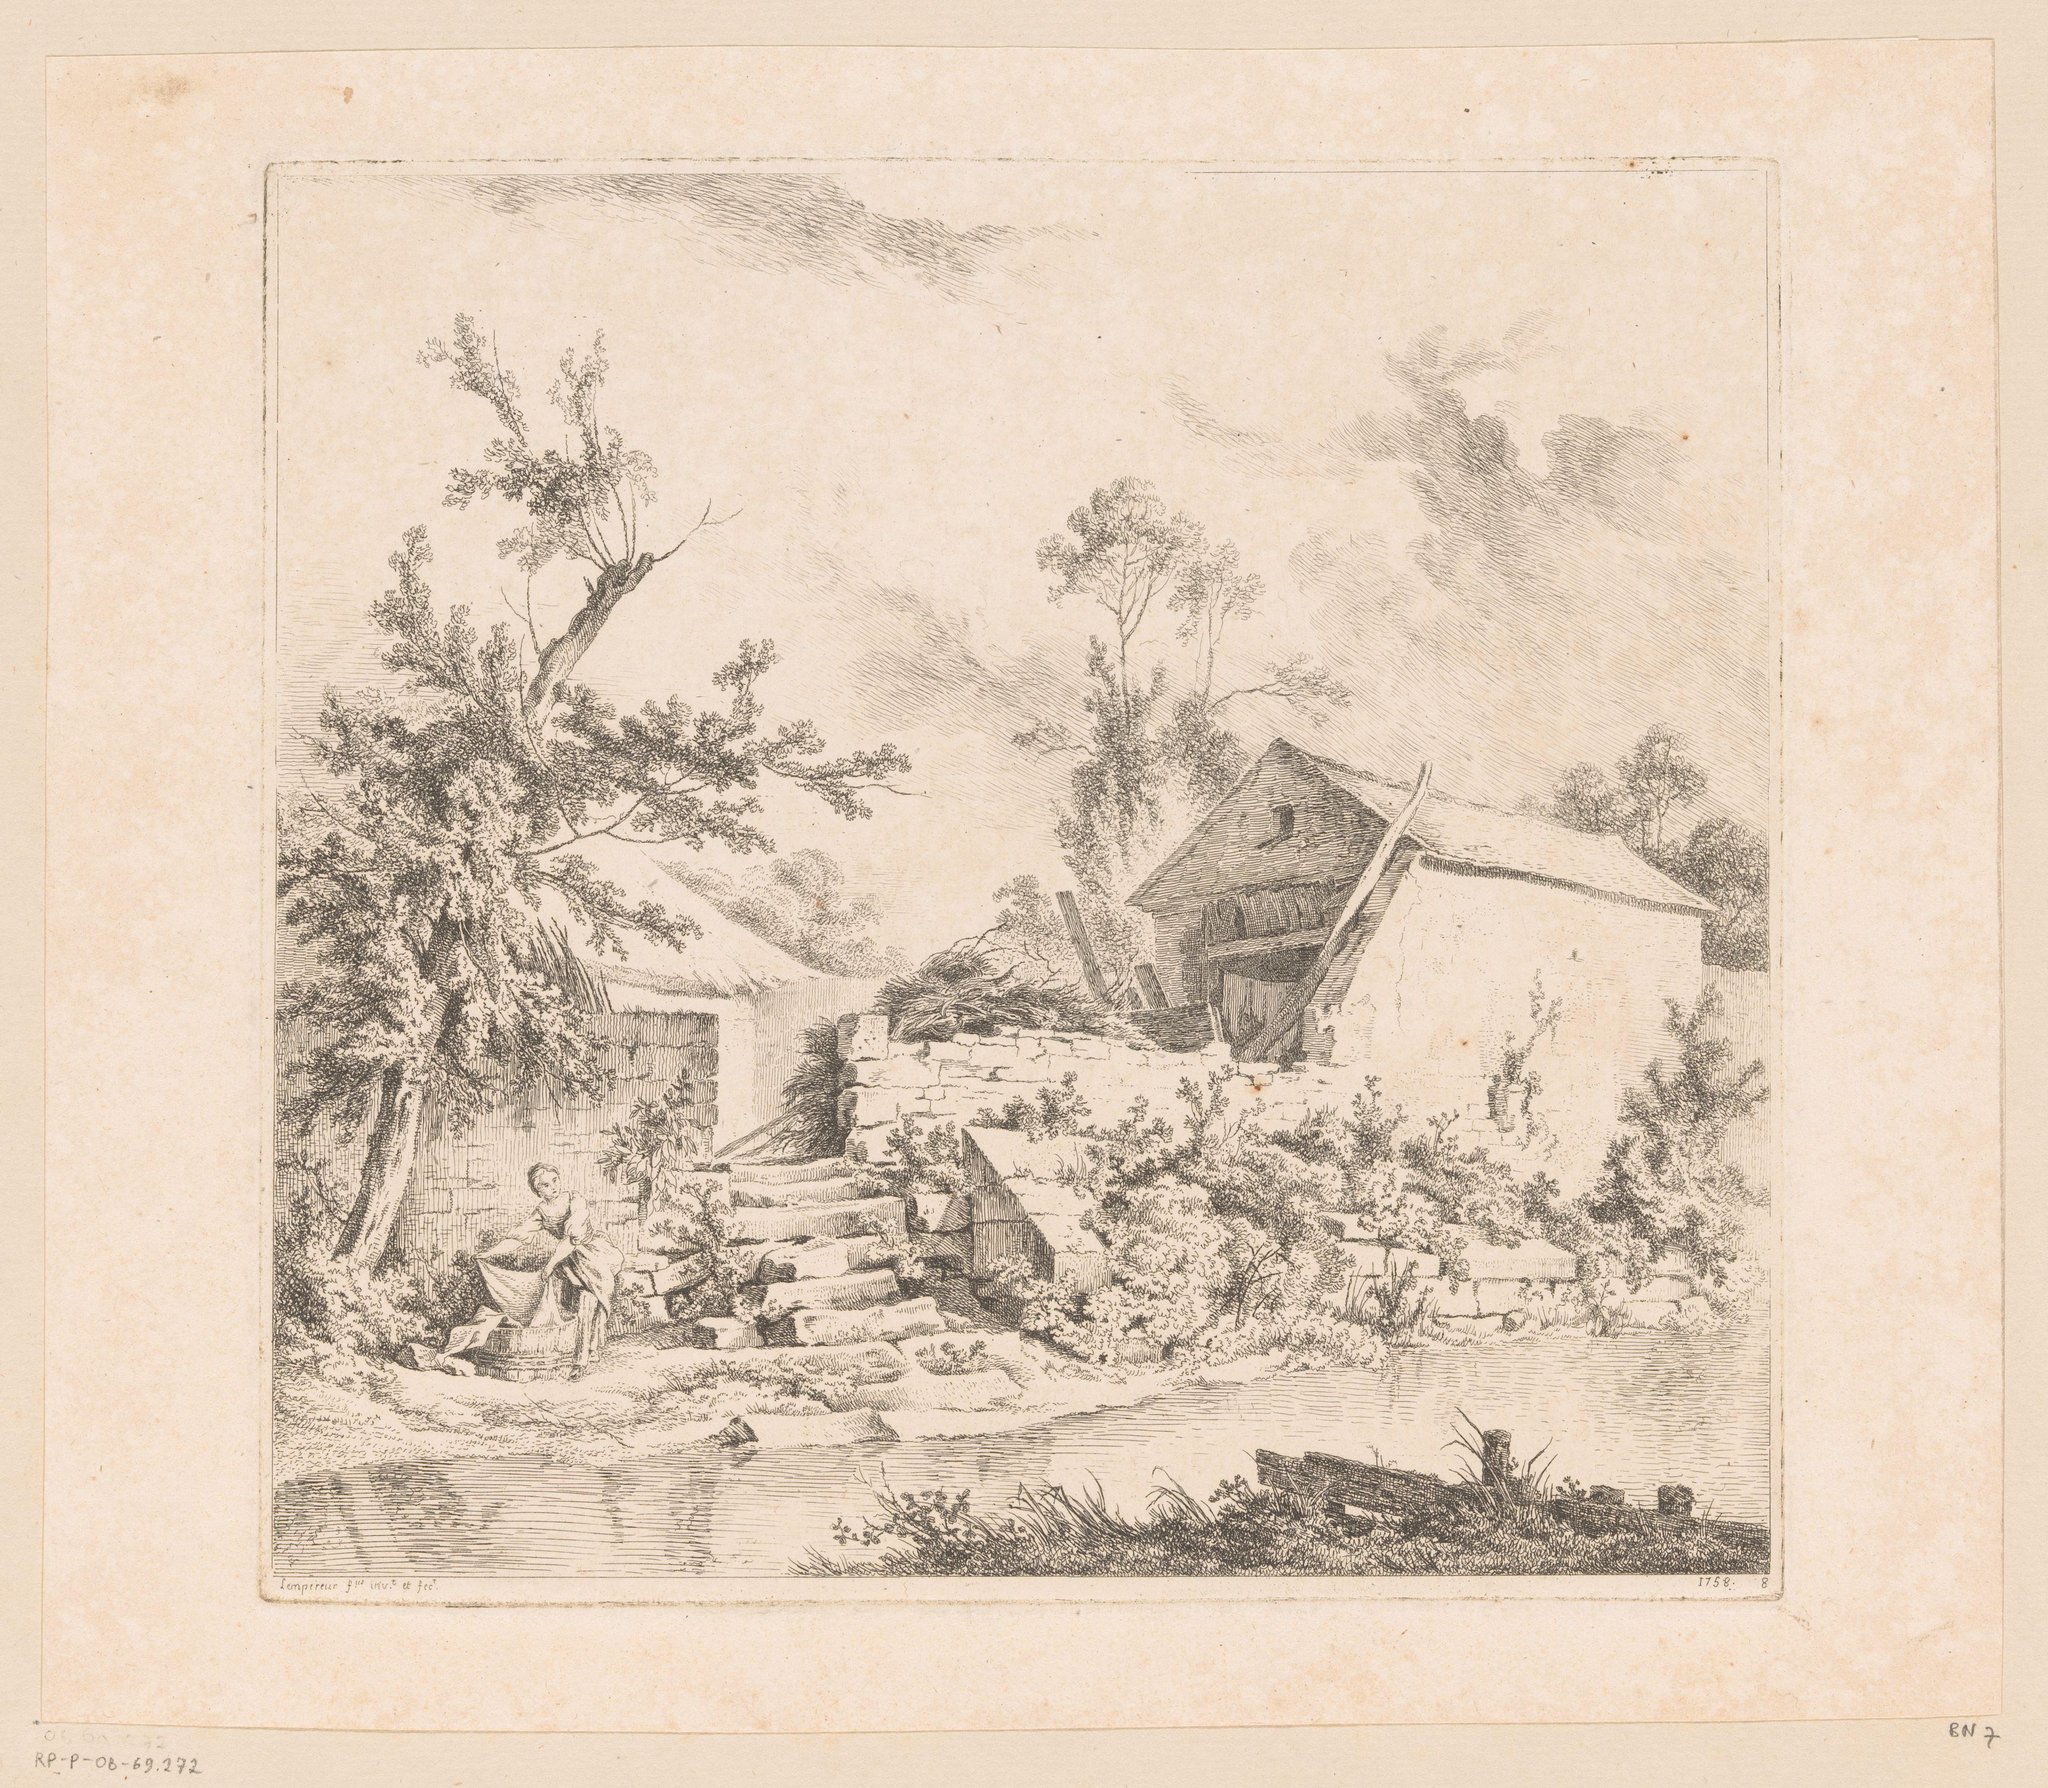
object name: print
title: Vrouw met wastobbe aan een waterloop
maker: jean baptiste denis lempereur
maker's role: print maker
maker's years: 1740-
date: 1758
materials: paper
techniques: engraving, etching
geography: france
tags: adult woman, landscapes with waters, waterscapes, seascapes (in the temperate zone), building or outbuilding where laundry is done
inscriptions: collector's mark: Lugt 240, watermark